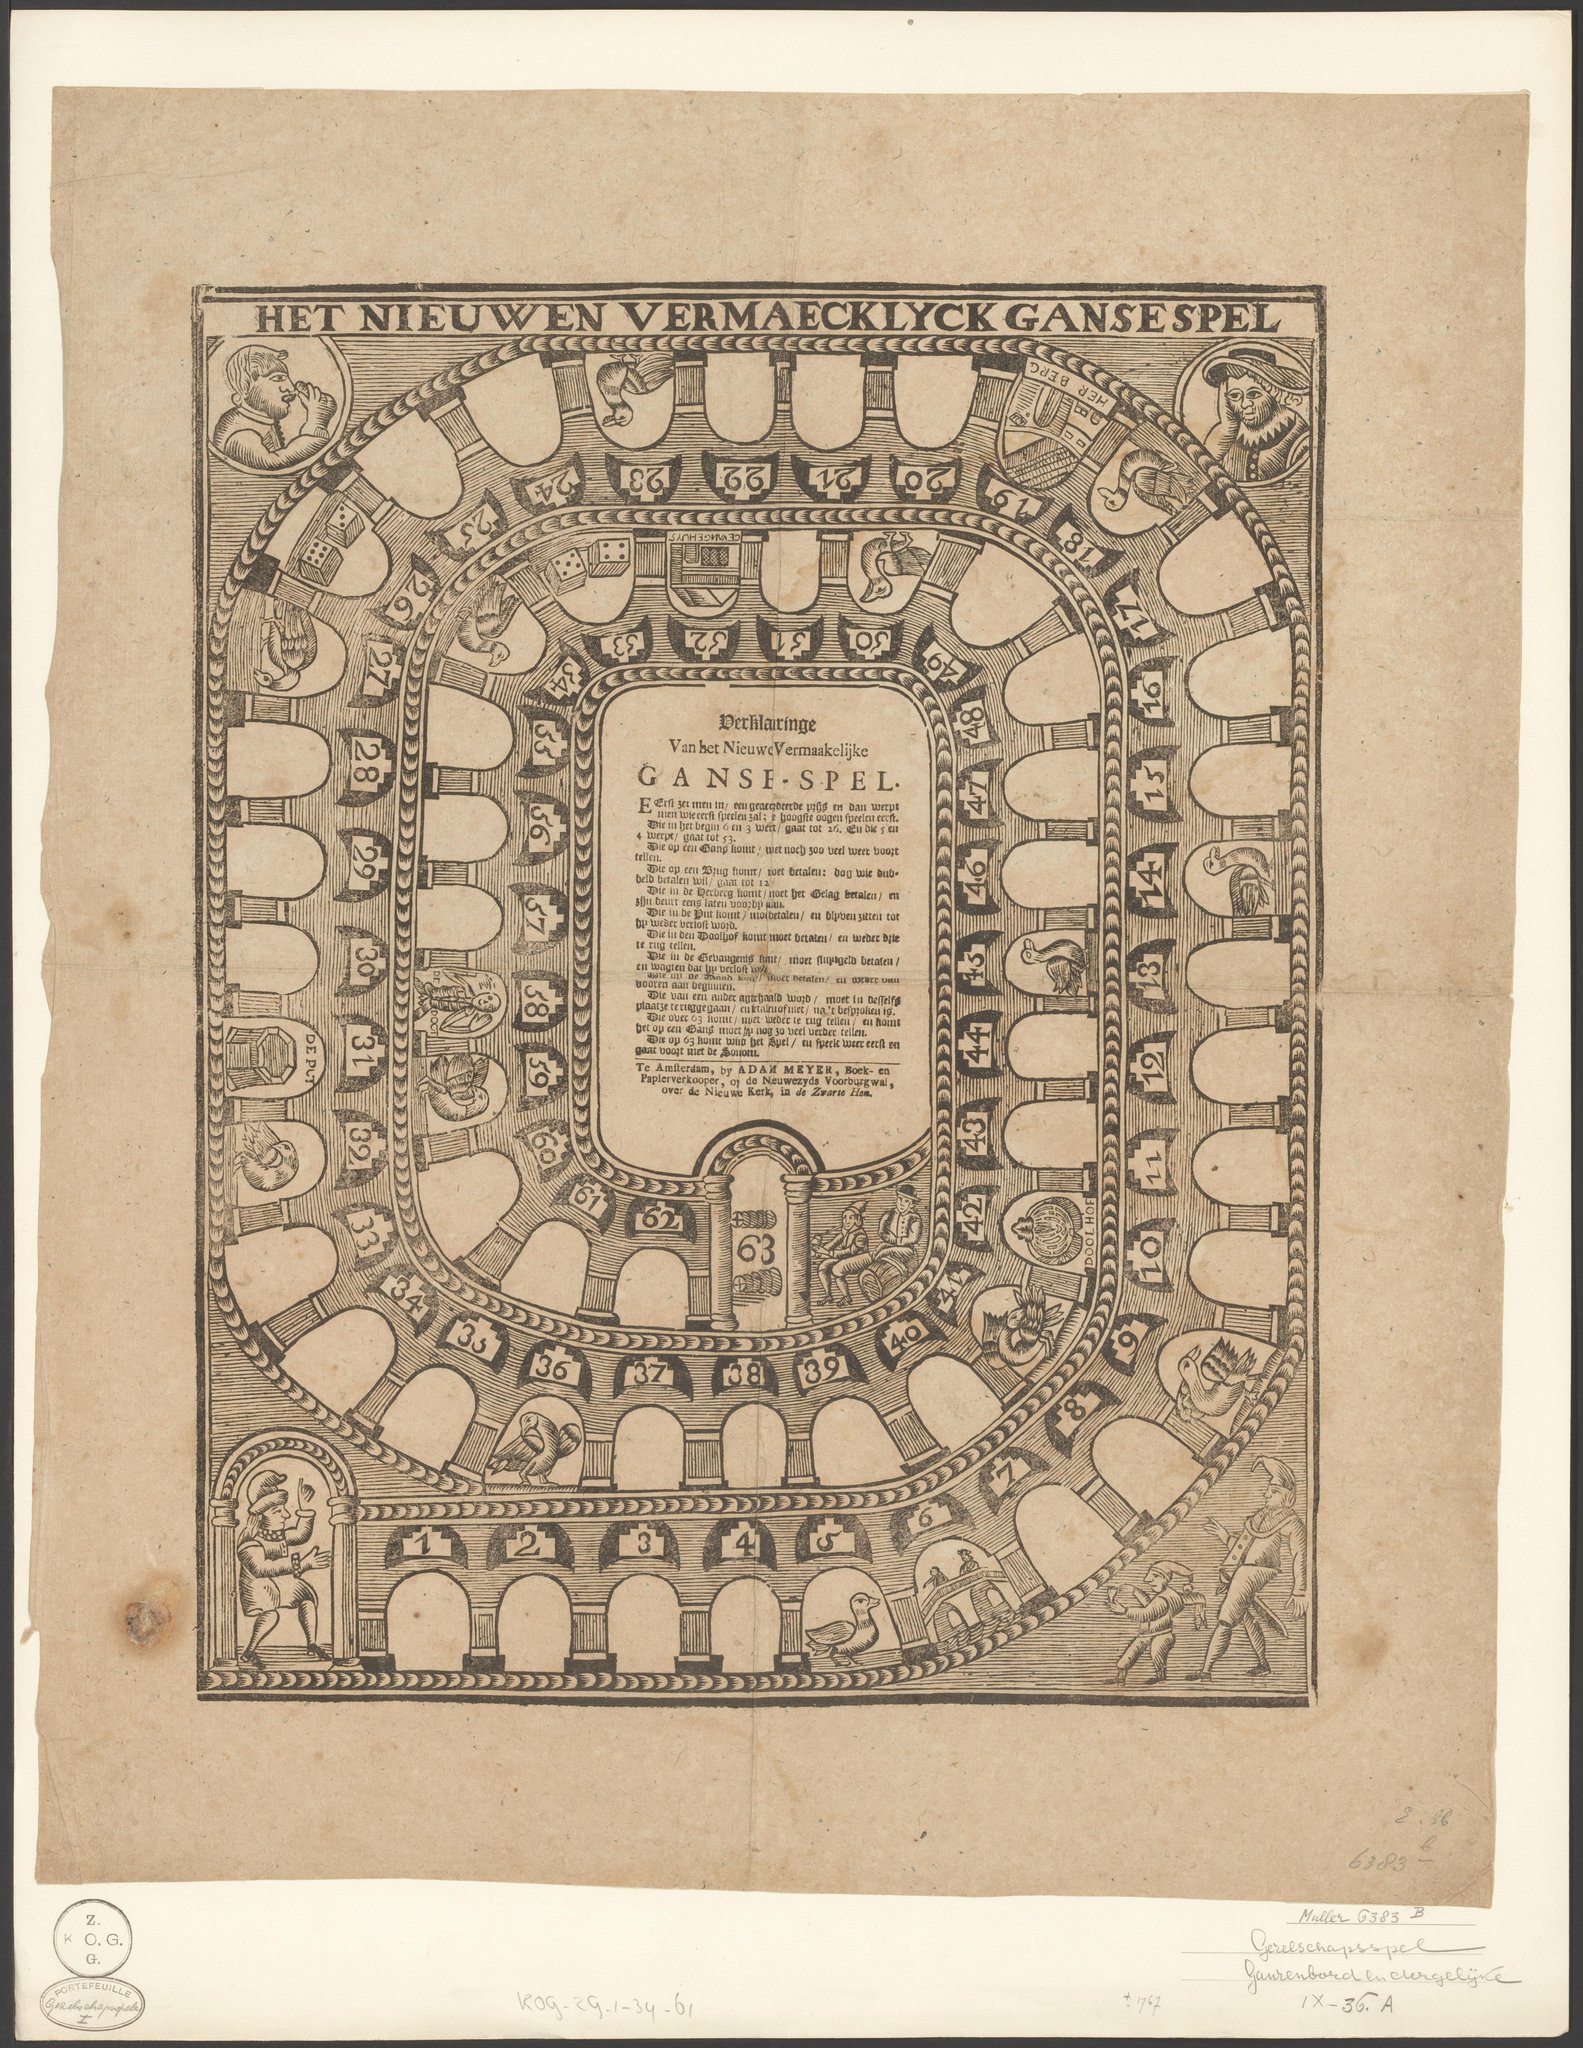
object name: gameboard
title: Het nieuwen vermaecklyck gansespel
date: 1780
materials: paper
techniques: letterpress printing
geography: amsterdam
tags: goose-game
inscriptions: collector's mark, collector's mark: Lugt 1641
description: Ganzenbordspel met 63 vakjes. In het midden de spelregels. Onderwerpsrubrieken binnen de Atlas Zeden en Gewoonten: Spel en Vermaak; gezelschapsspel, ganzenbord en dergelijke.